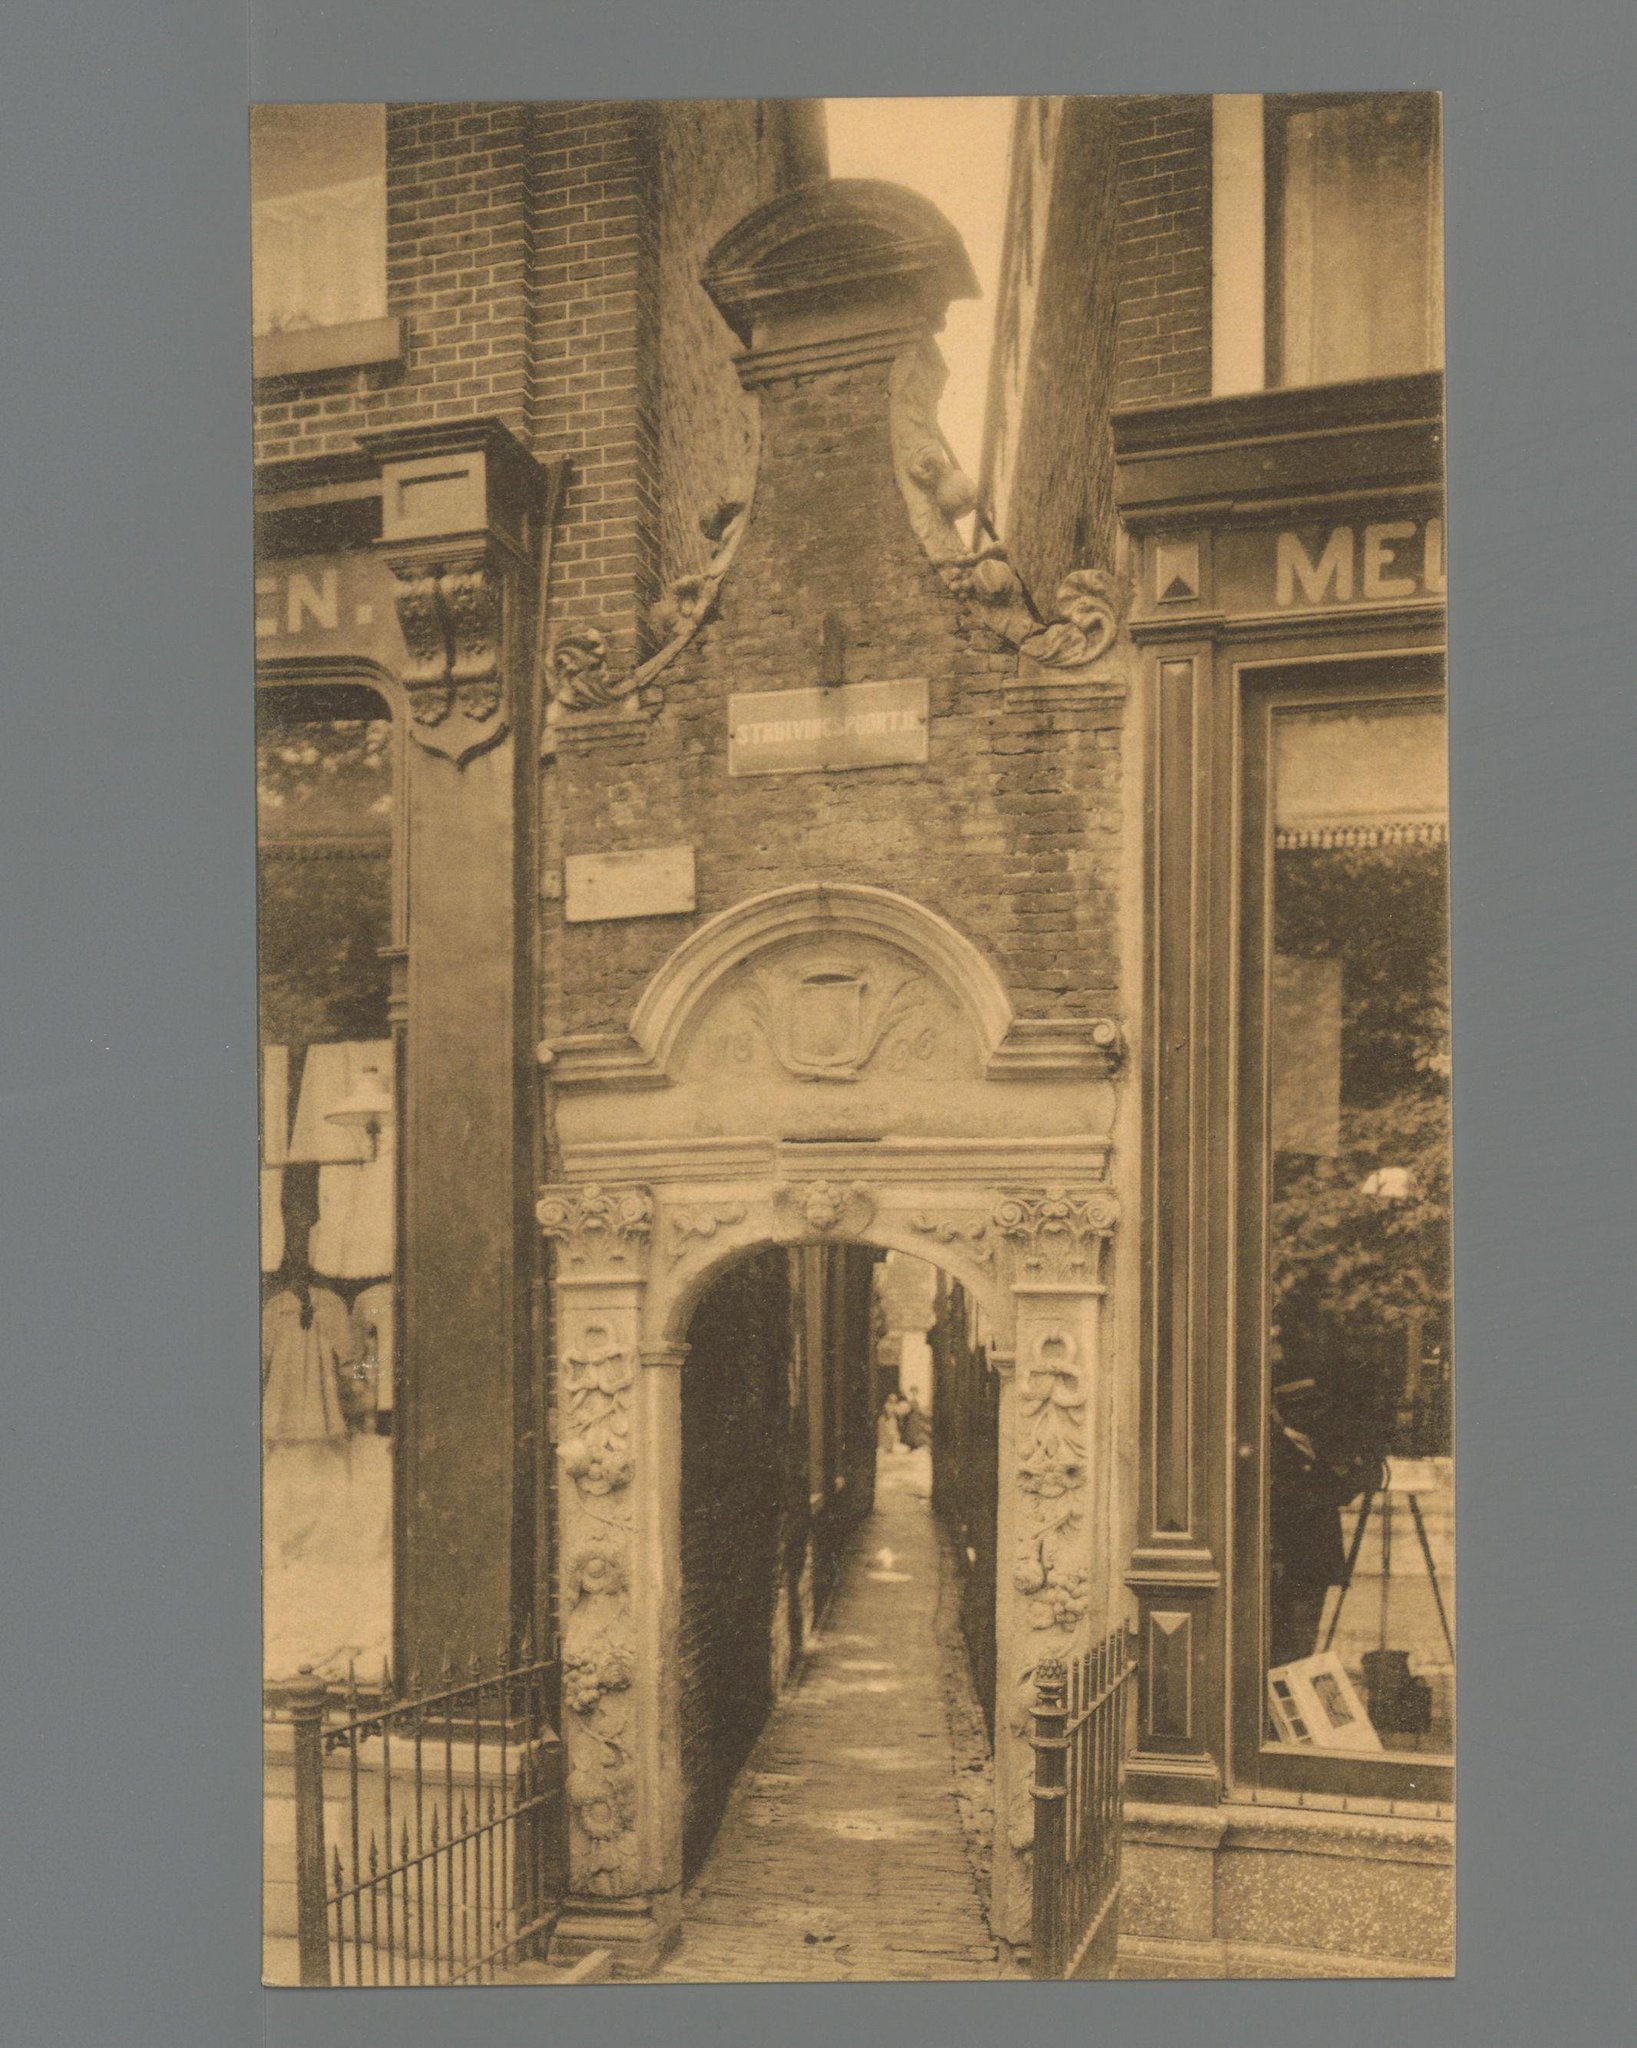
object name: photomechanical print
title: Leeuwarden. Struivingspoortje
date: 1905-1930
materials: cardboard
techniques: photograph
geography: leeuwarden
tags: gate, entrance